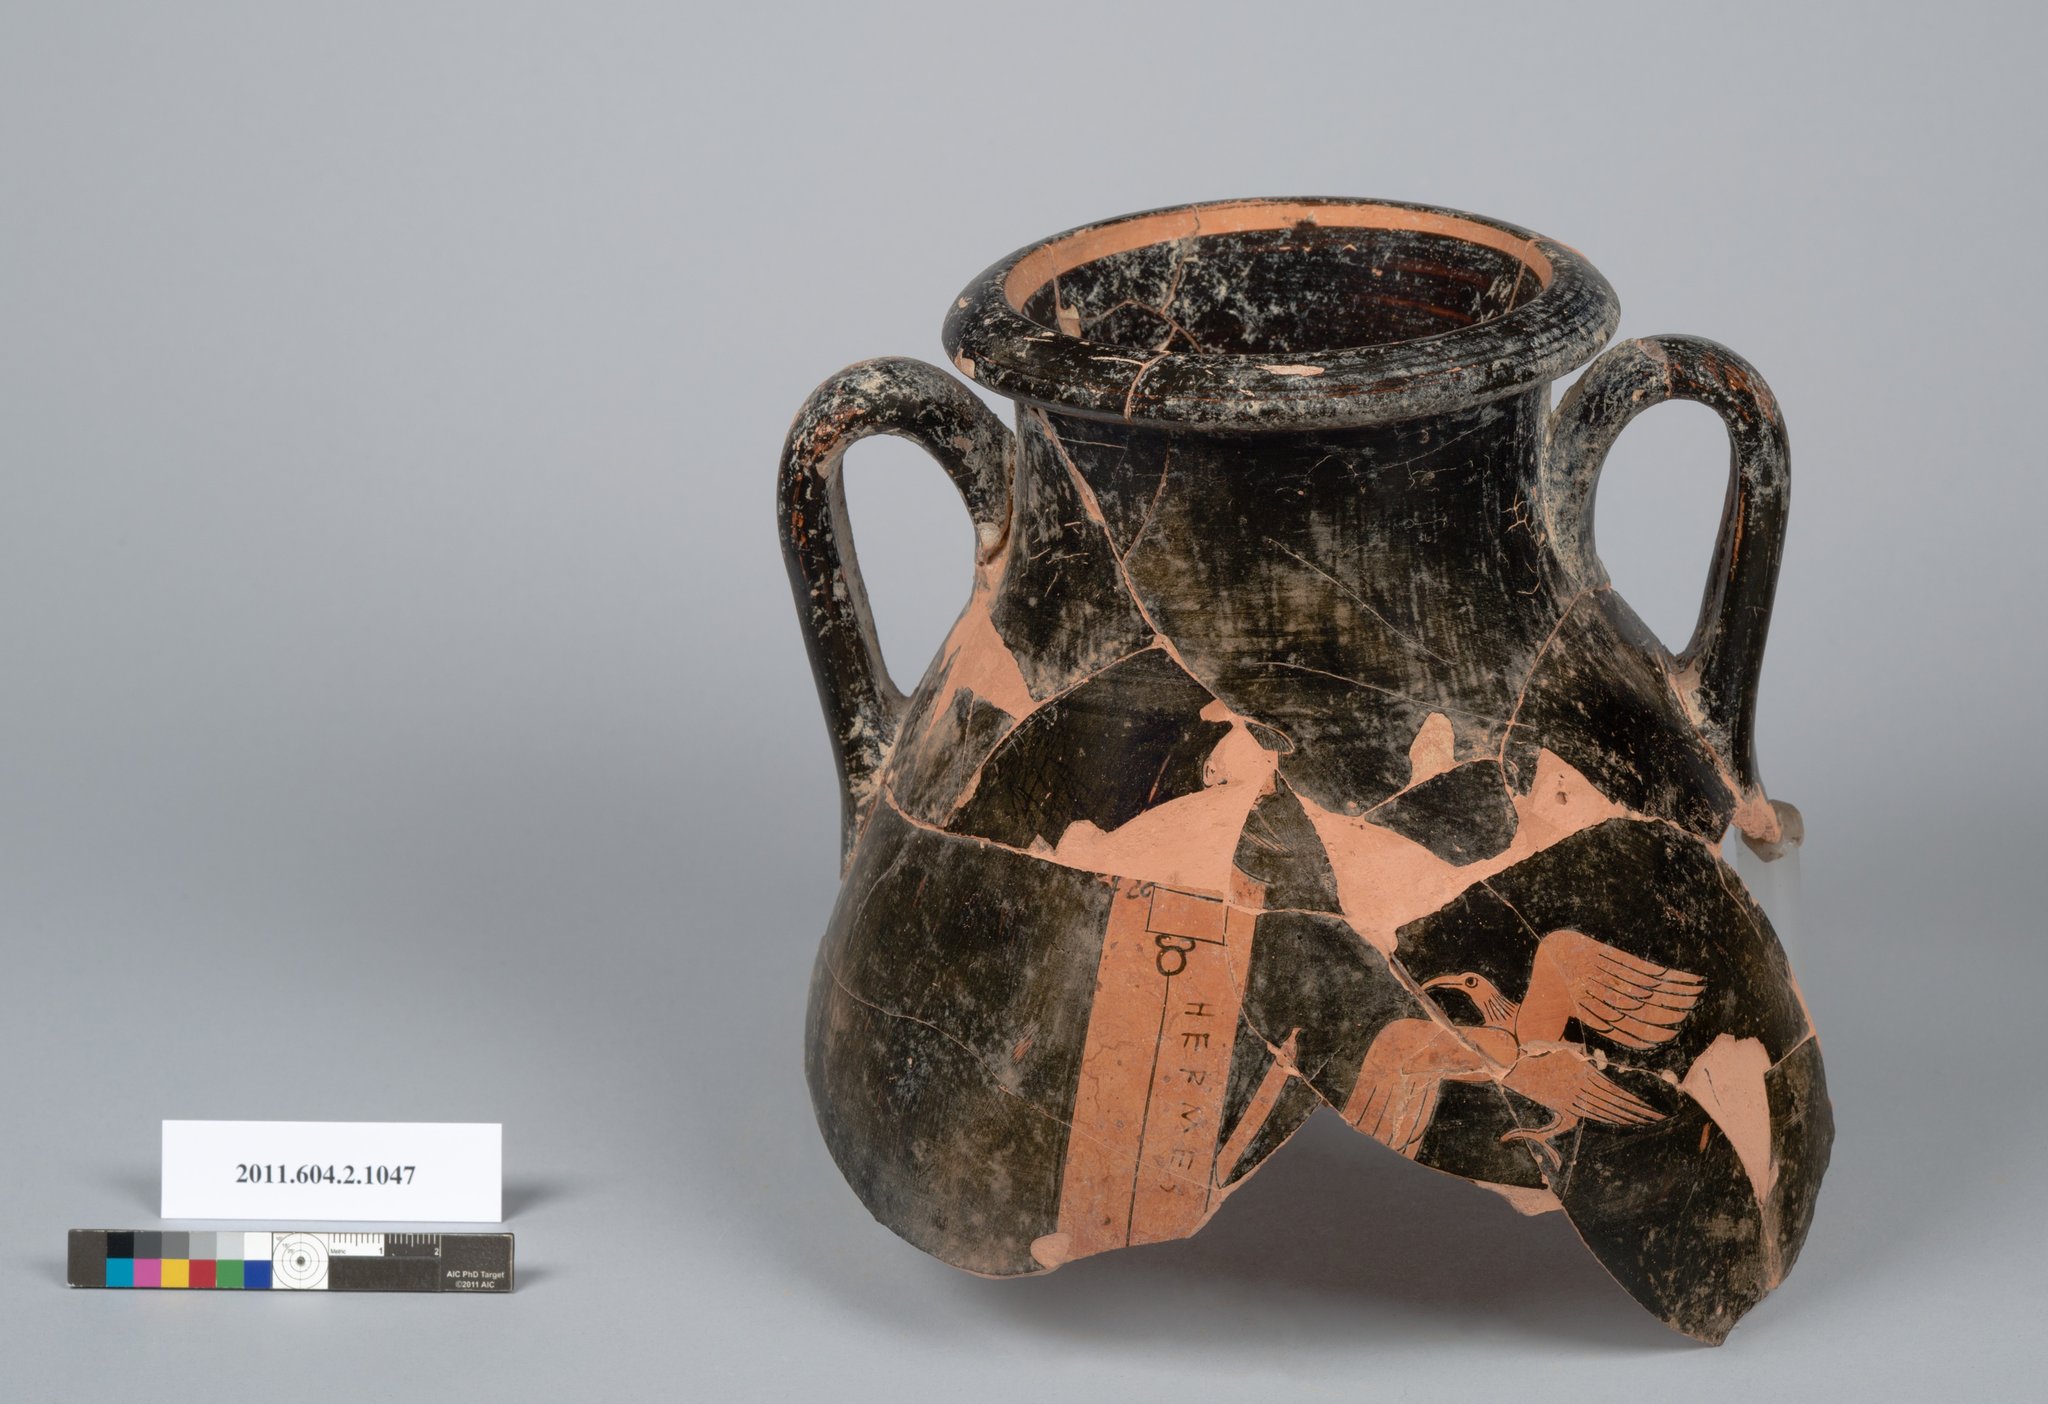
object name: pelike fragment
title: Terracotta fragment of a pelike (jar)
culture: greek, attic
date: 480-470 BCE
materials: terracotta